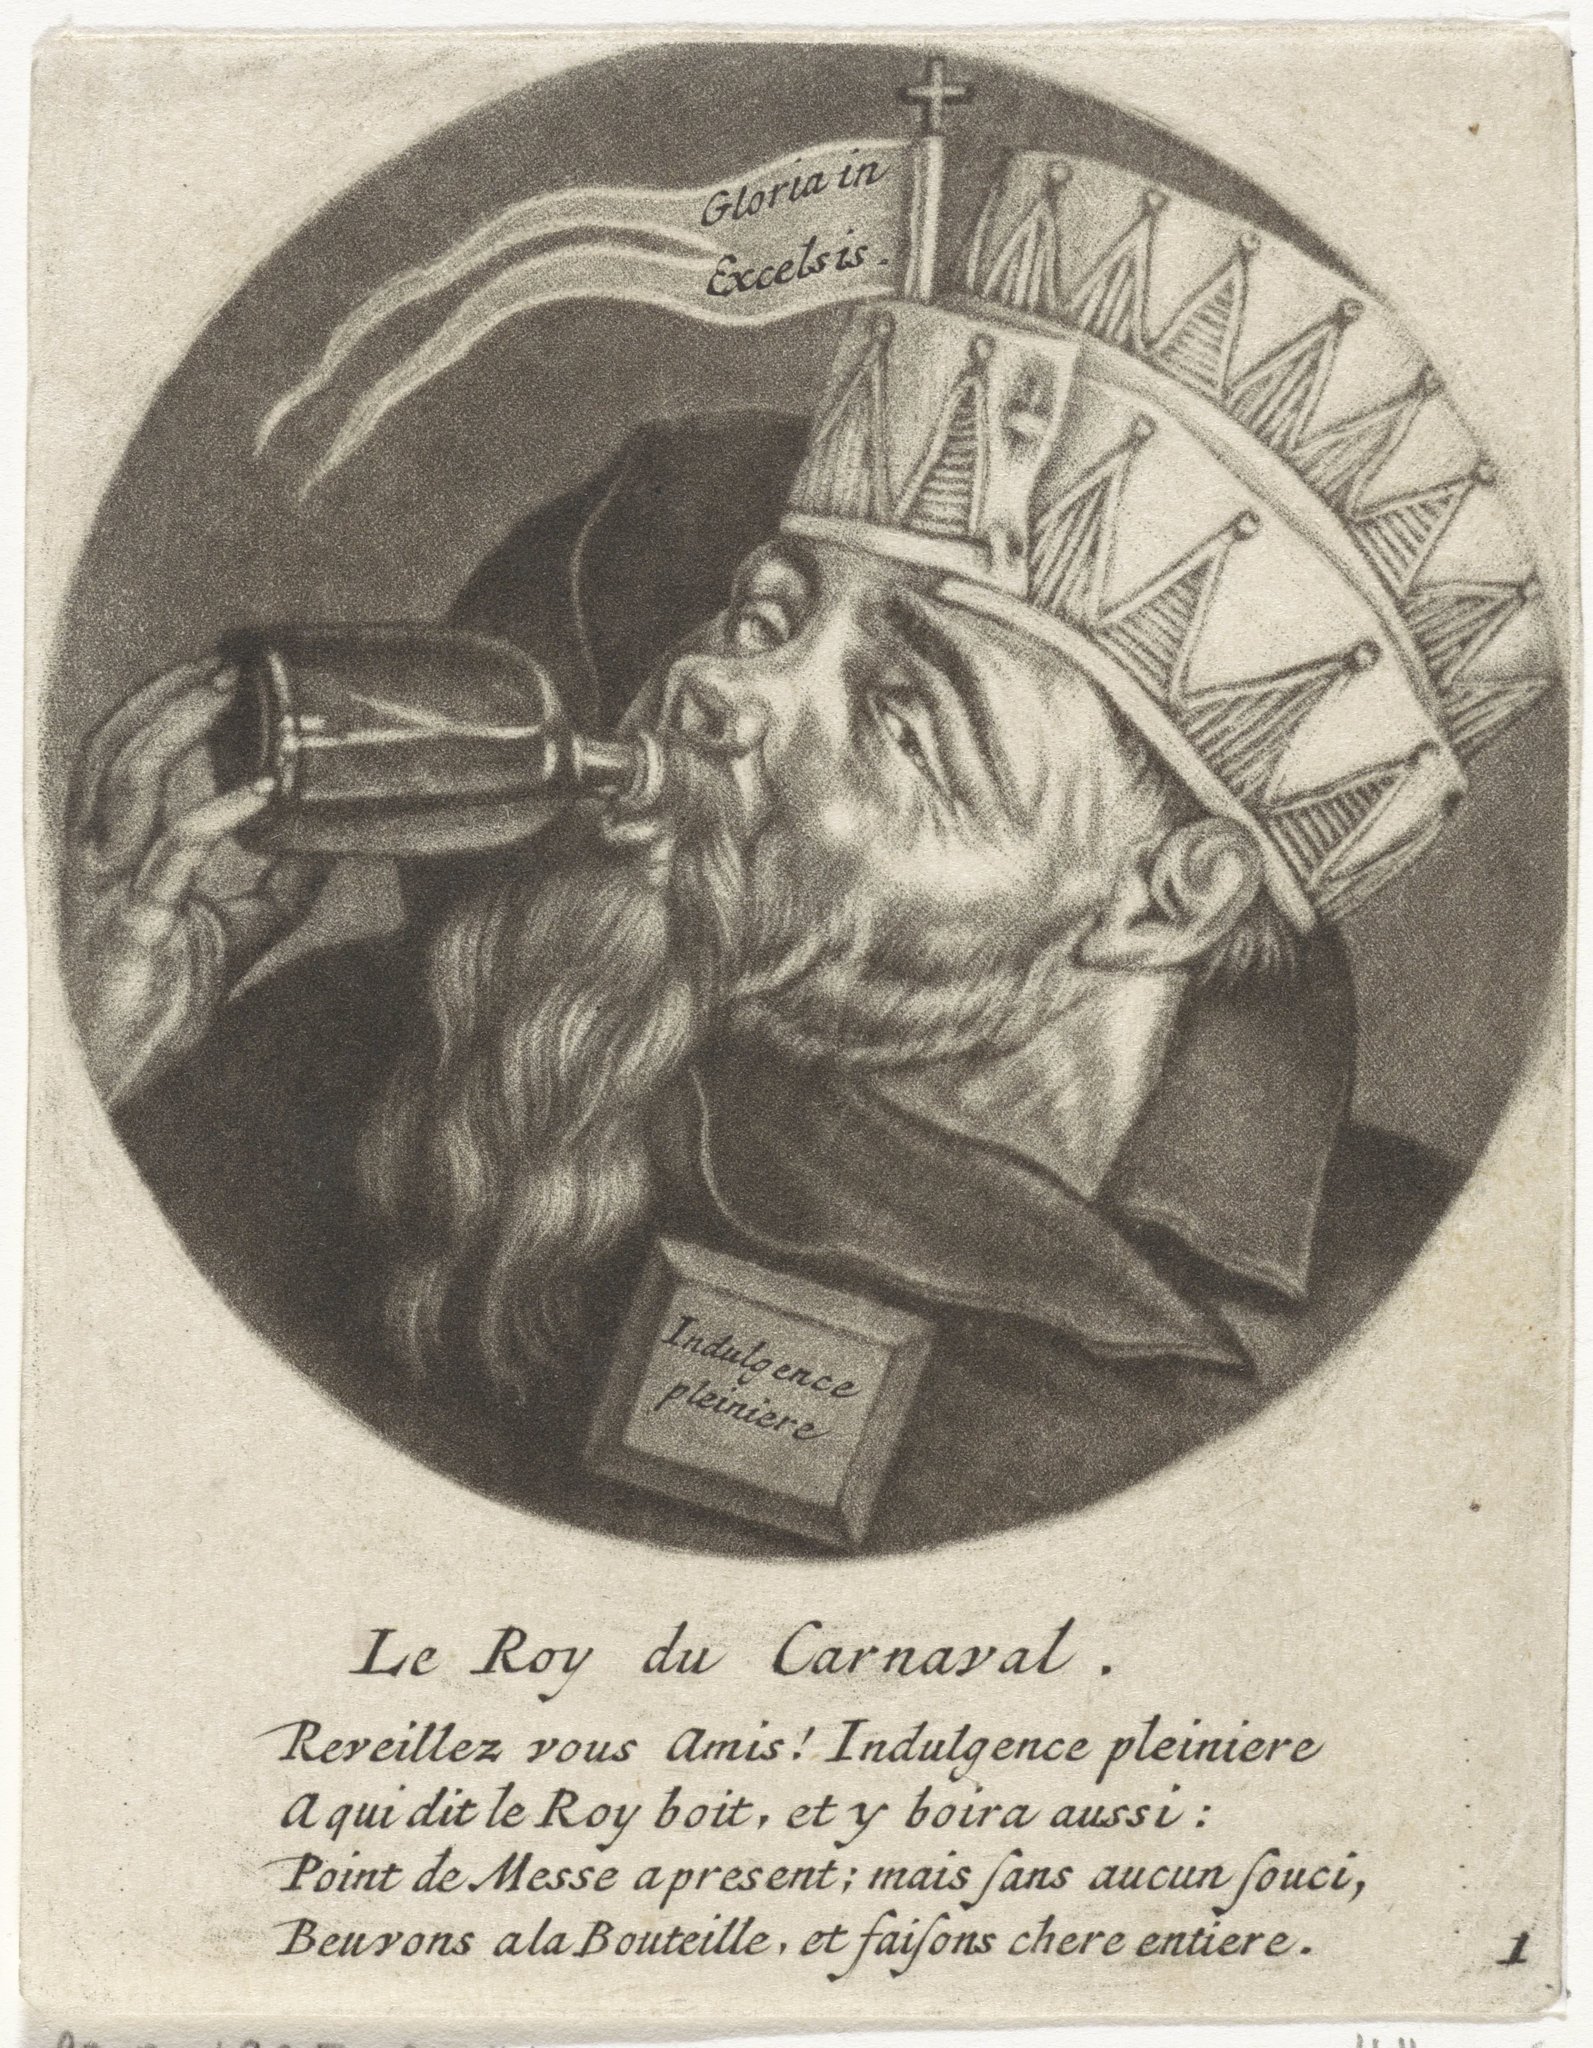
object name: print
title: Caricatures of the French clergy under Louis XIV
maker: jacob gole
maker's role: print maker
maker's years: 1660-1724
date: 1670-1724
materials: paper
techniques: engraving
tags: monk(s), friar(s), carnival, shrovetide (non-liturgical celebration), political caricatures and satires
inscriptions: collector's mark: Lugt 2228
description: Cornelis Dusart and Jacob Gole collaborated on these two series of virulent anti-Catholic caricatures. This series consists of more than fifty prints of monks and nuns who embody sinful behaviour, vice and abuses within the Catholic Church. The heads (no portraits of historical individials but caricatures) exhibit attributes and traces of gluttony, heavy drinking, false piety and lust.